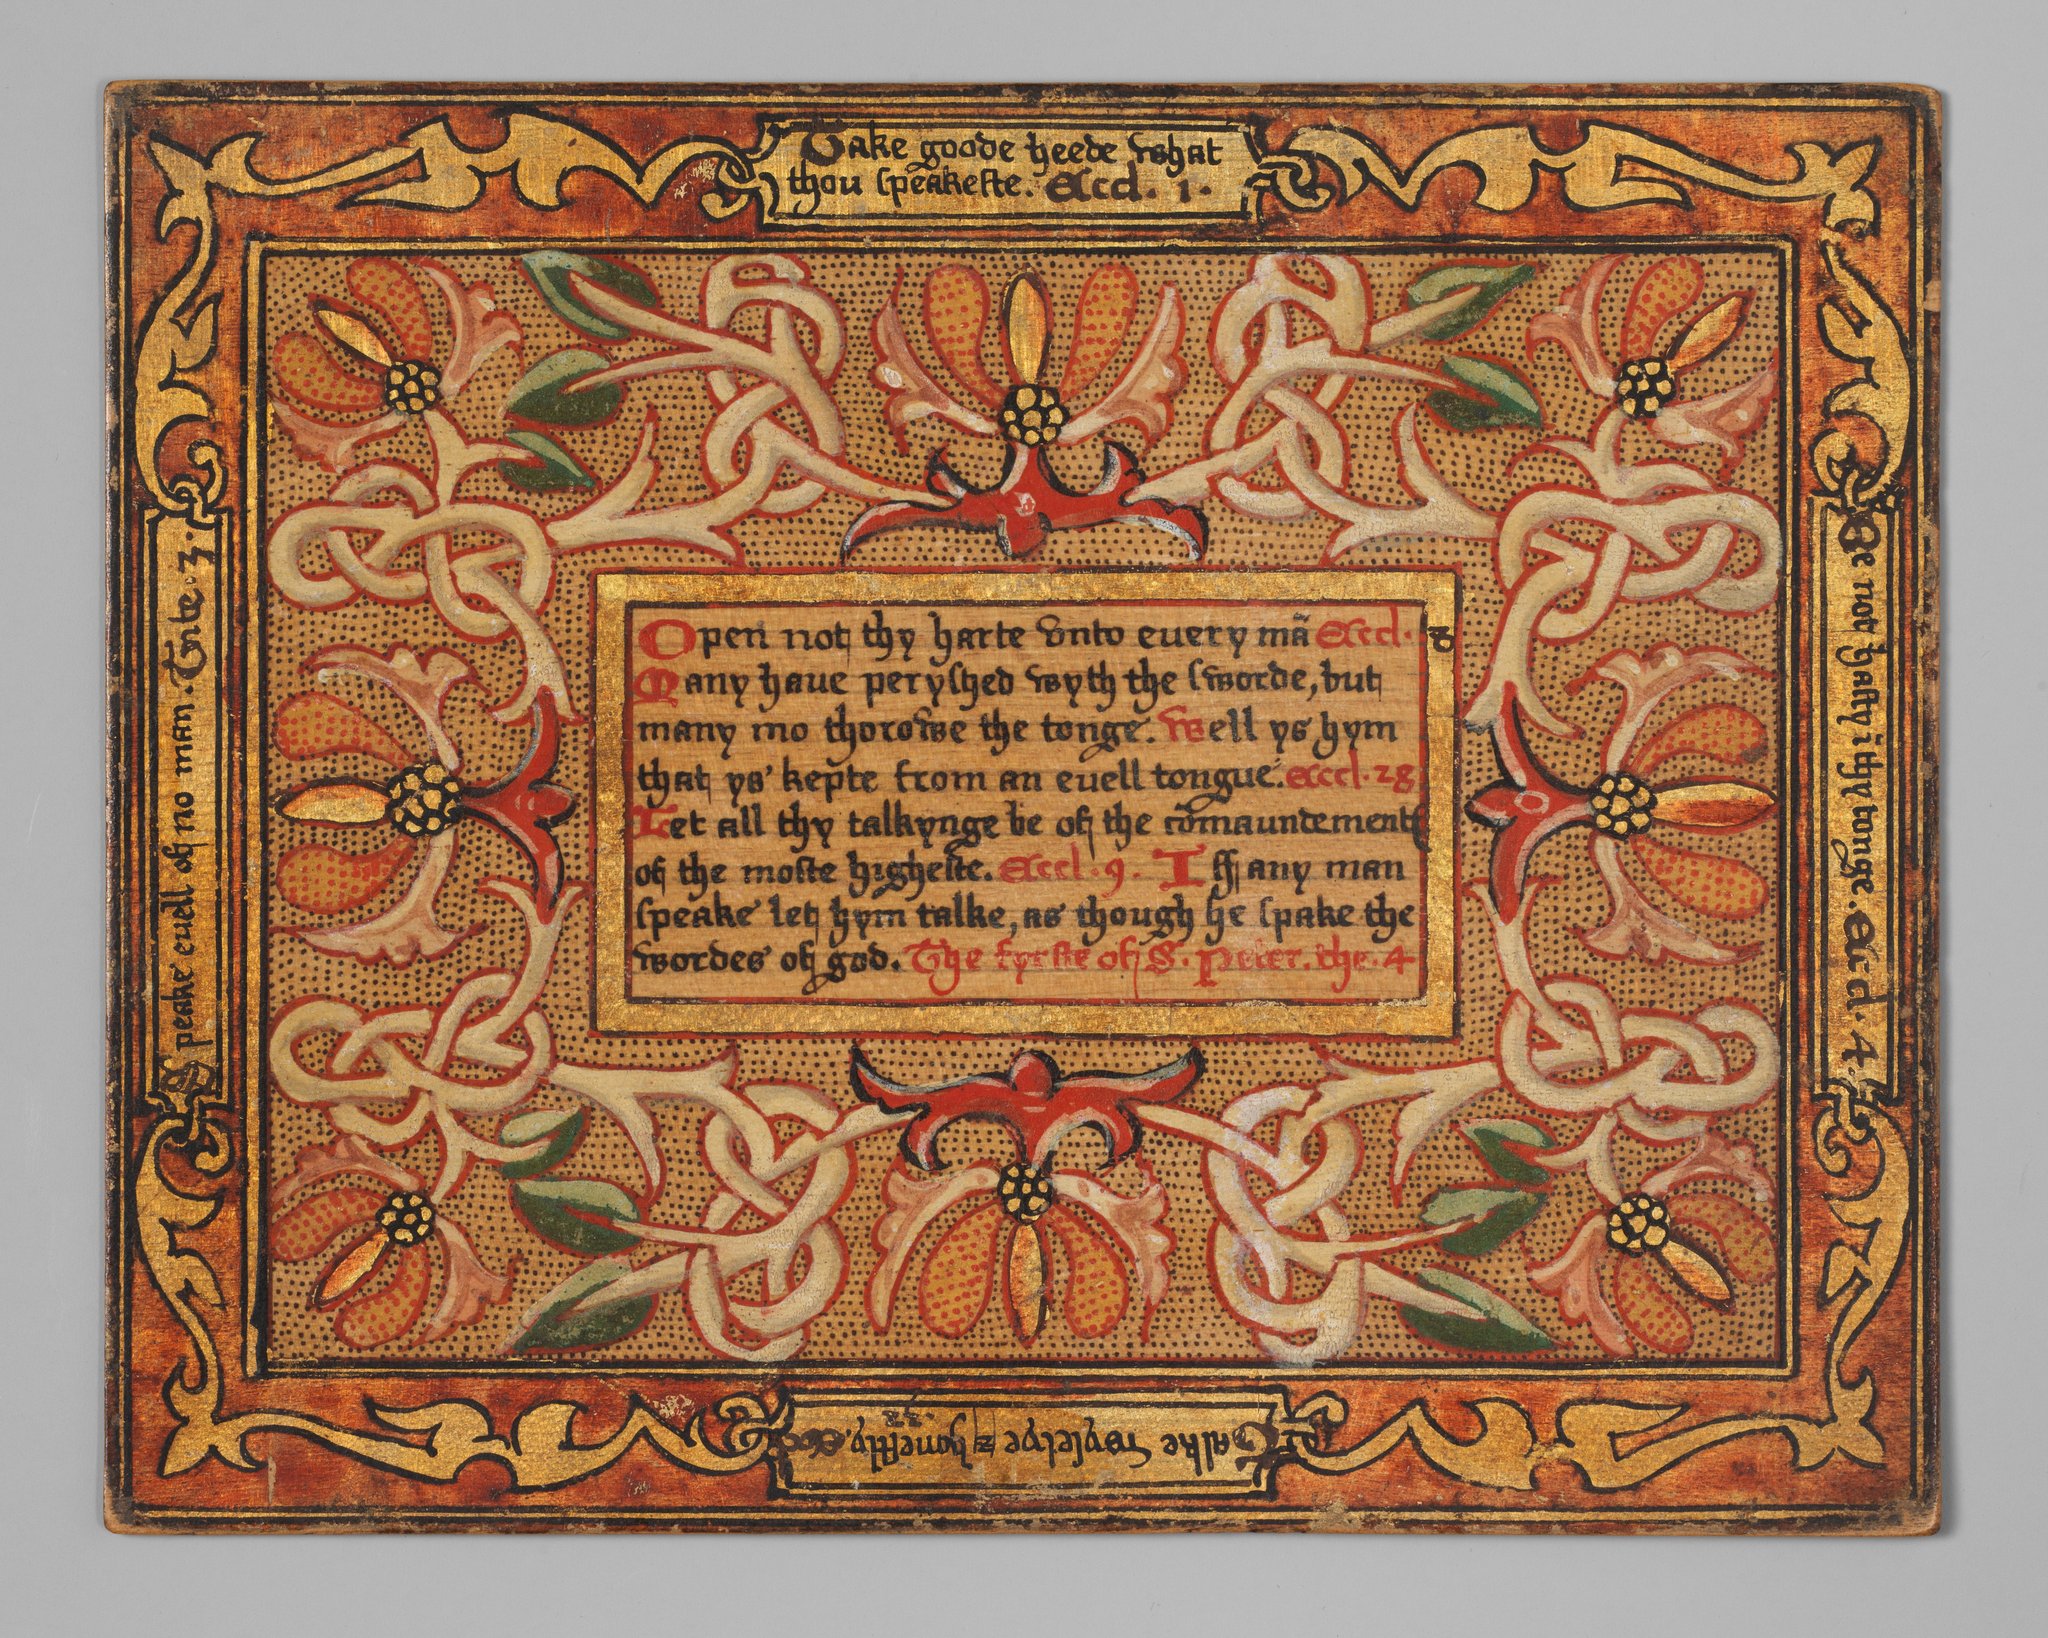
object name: trencher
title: Trencher with quotation from The Governance of Virtue (1566) (one of a set)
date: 1601-1633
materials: wood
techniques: gilding, painting